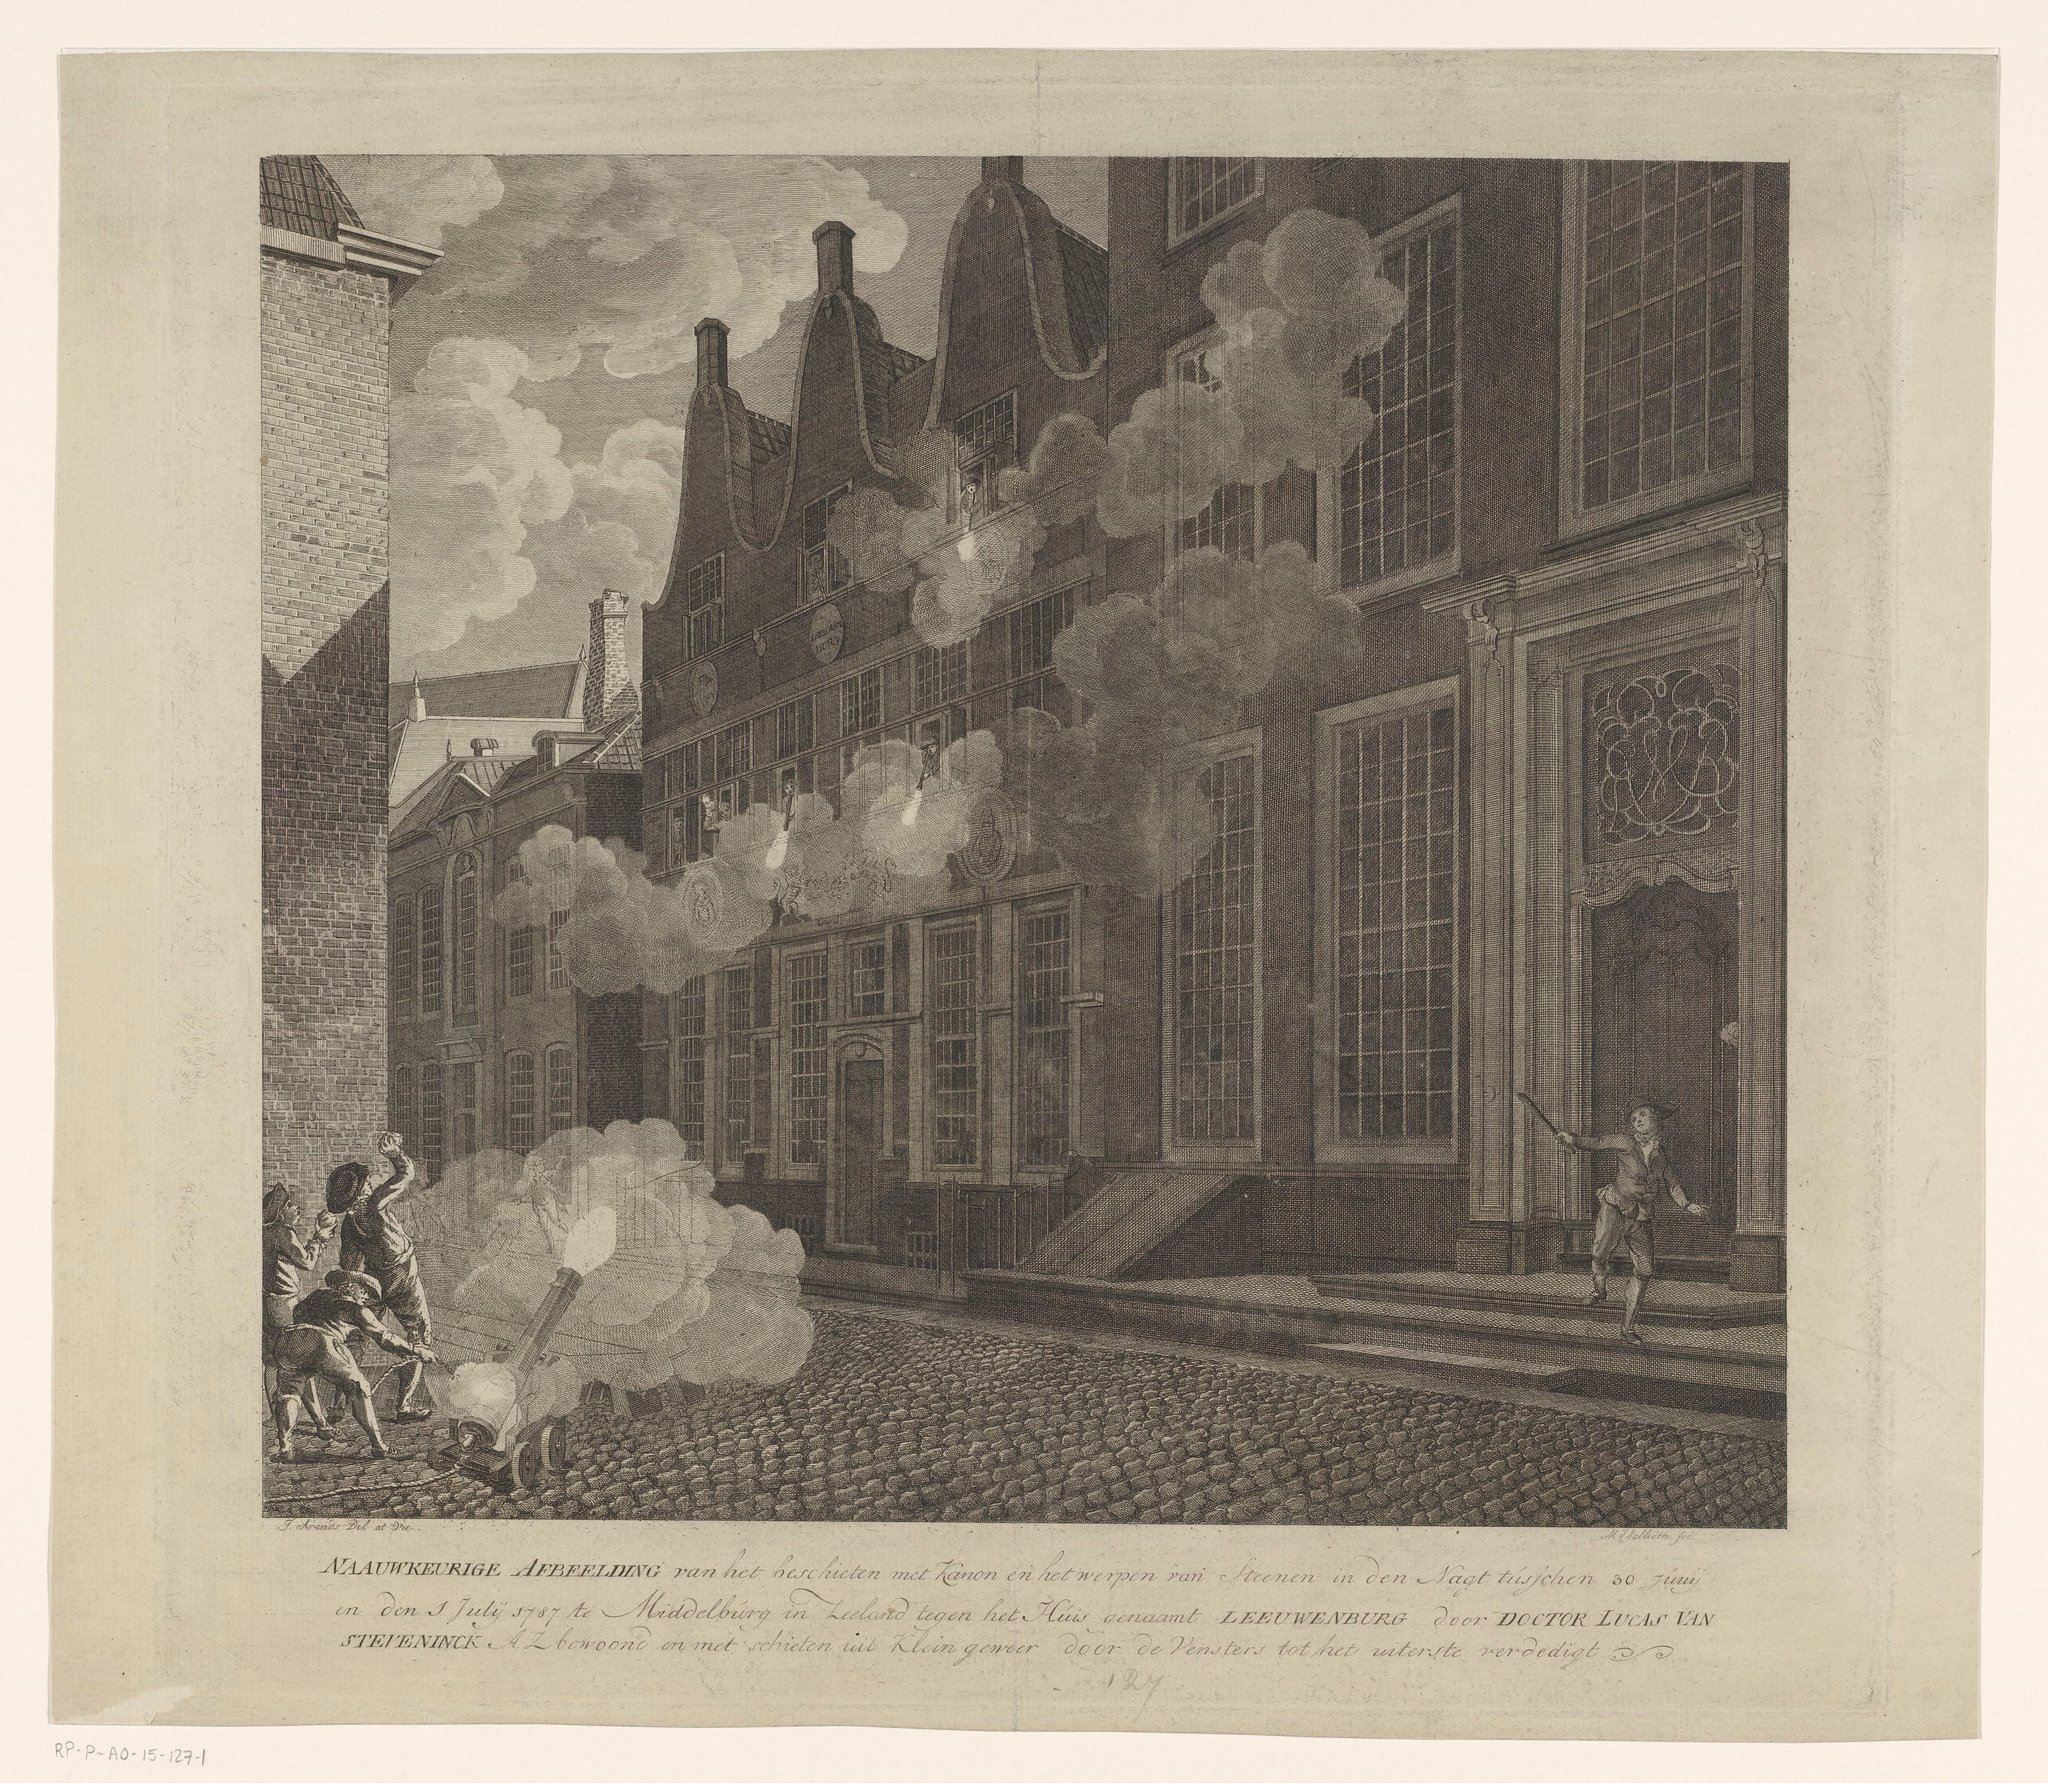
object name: print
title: Beschieting van het huis van Lucas van Steveninck, 1787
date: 1787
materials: paper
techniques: engraving, etching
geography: rotterdam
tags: amsterdam, street-fights, riots, patriots (1780-1795)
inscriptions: collector's mark: Lugt 2228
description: Oranjegezinden beschieten met een klein kanon het Huis Leeuwenburg te Middelburg van de patriotse arts Lucas van Steveninck, in de nacht van 30 juni op 1 juli 1787. De bewoners schieten vanuit de vensters van het huis met geweren terug.